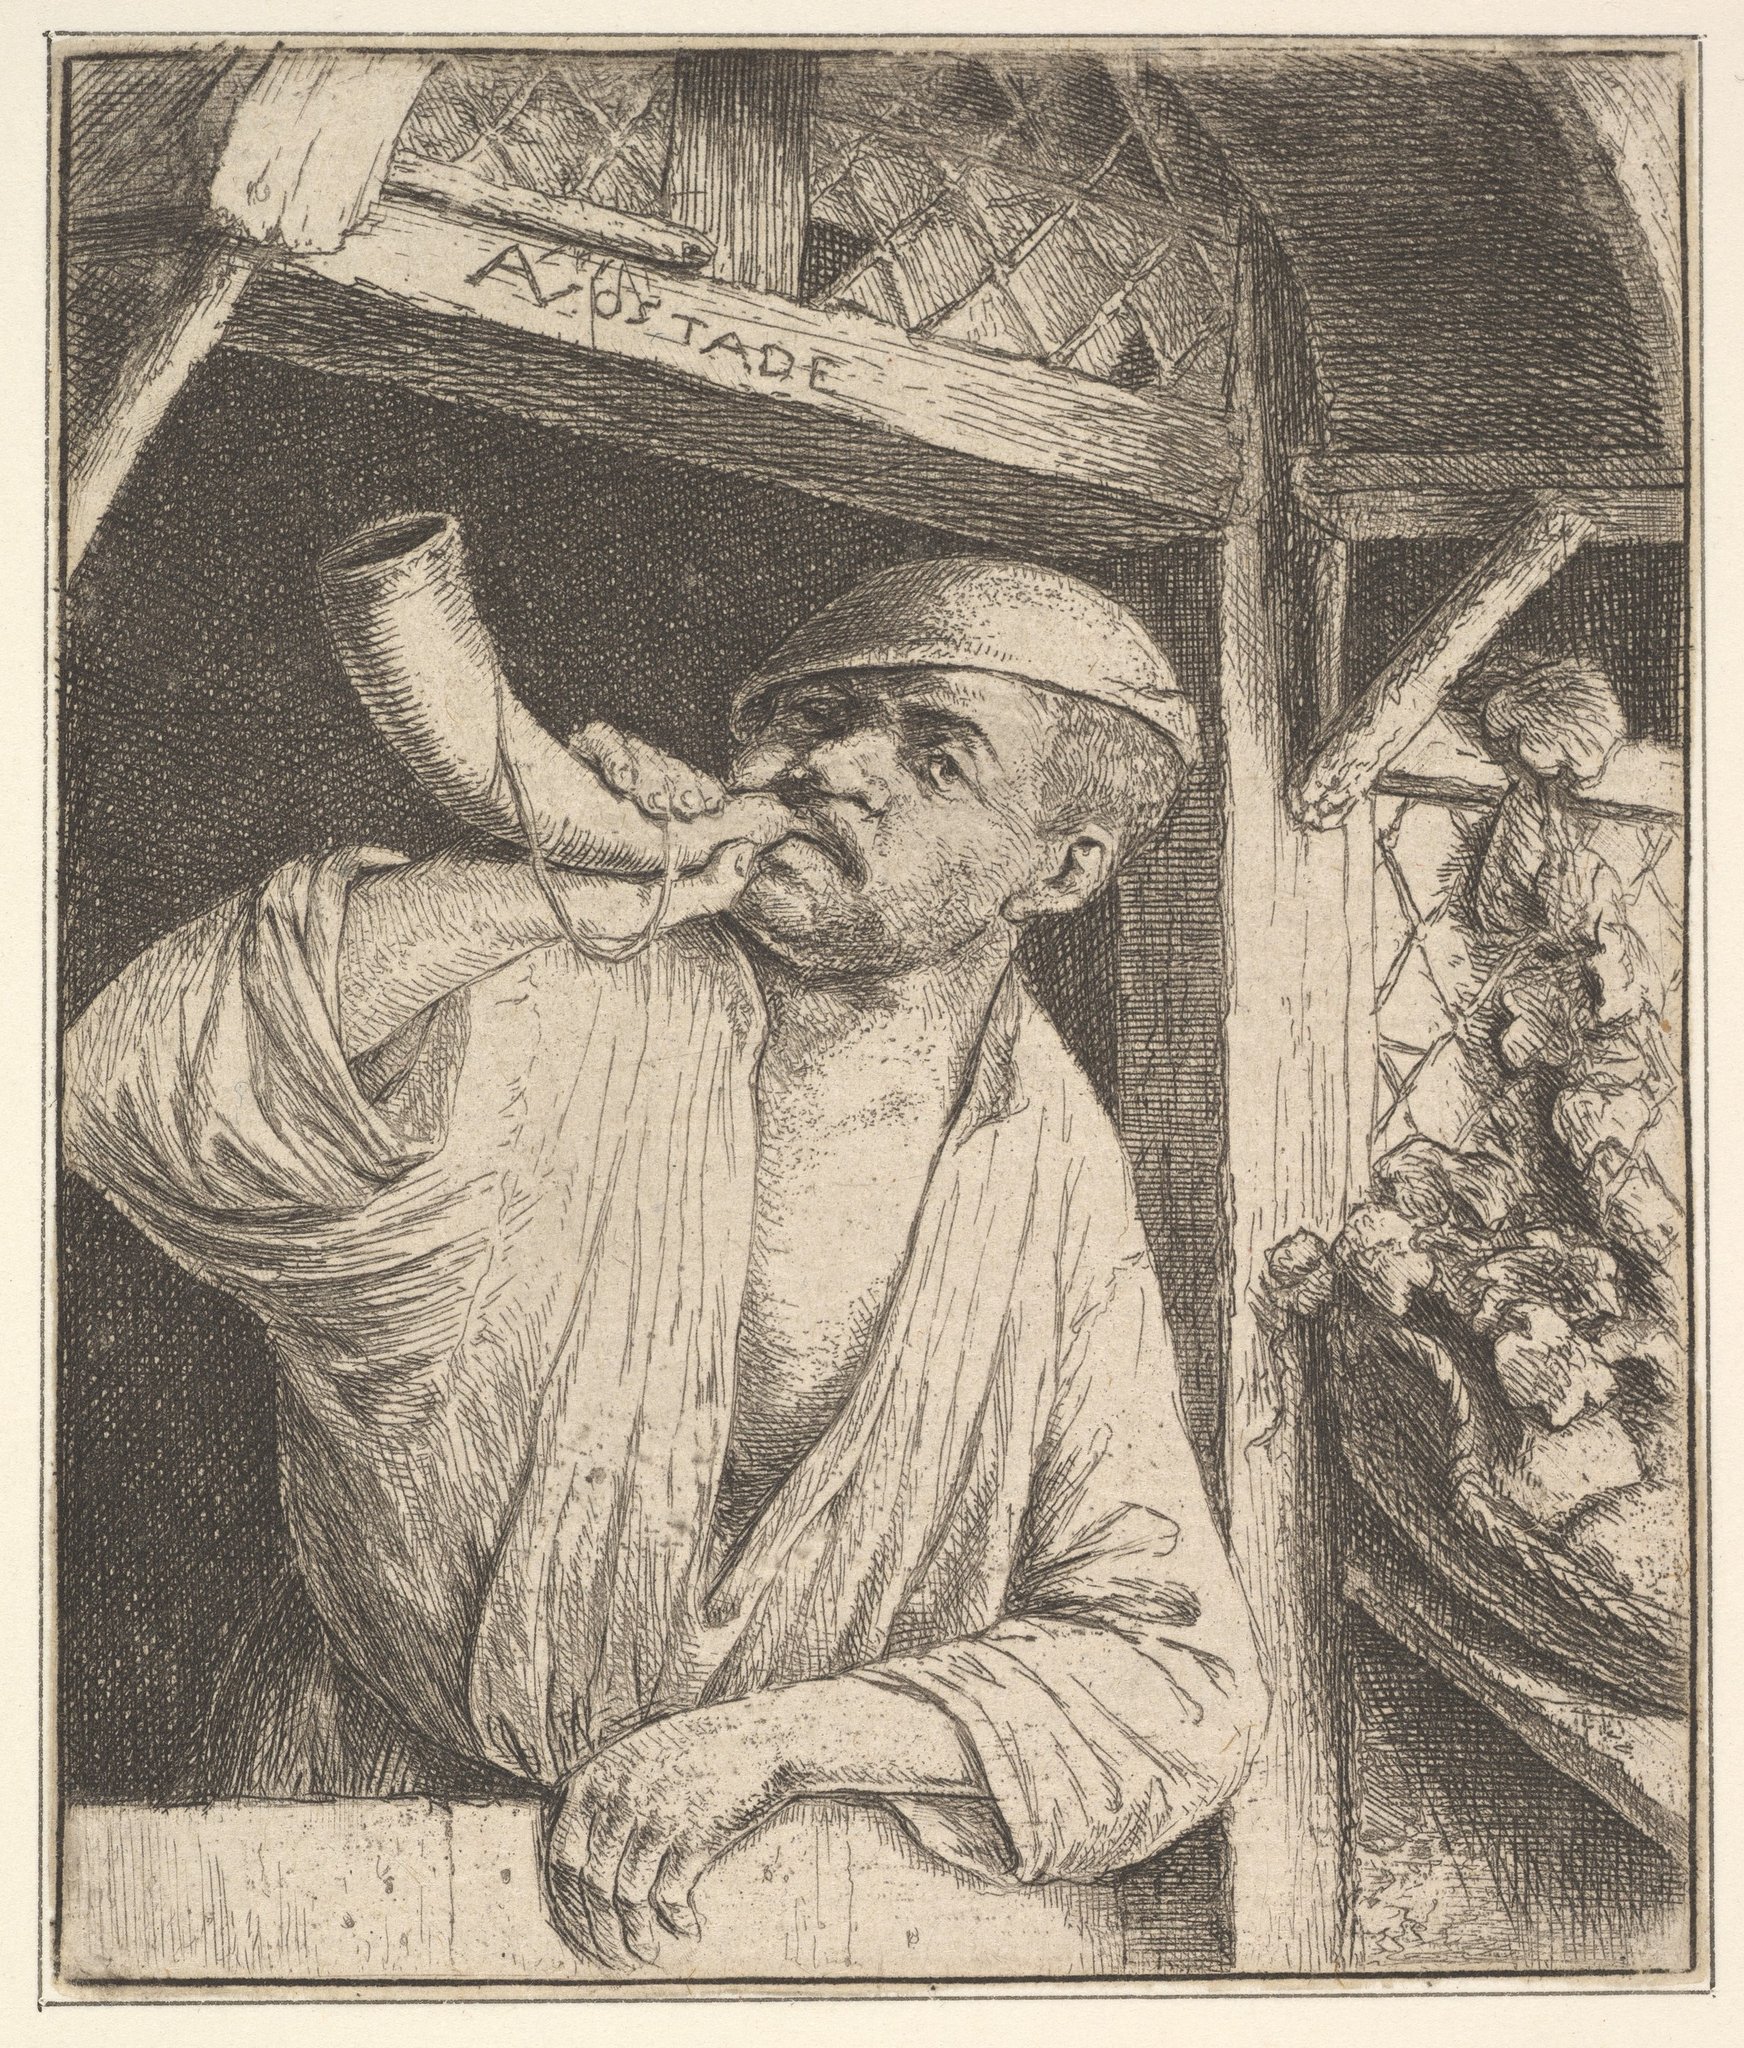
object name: print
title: Baker Blowing Horn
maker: adriaen van ostade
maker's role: artist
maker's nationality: dutch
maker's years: 1610-1685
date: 1610-1685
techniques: etching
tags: men,horns,bakers